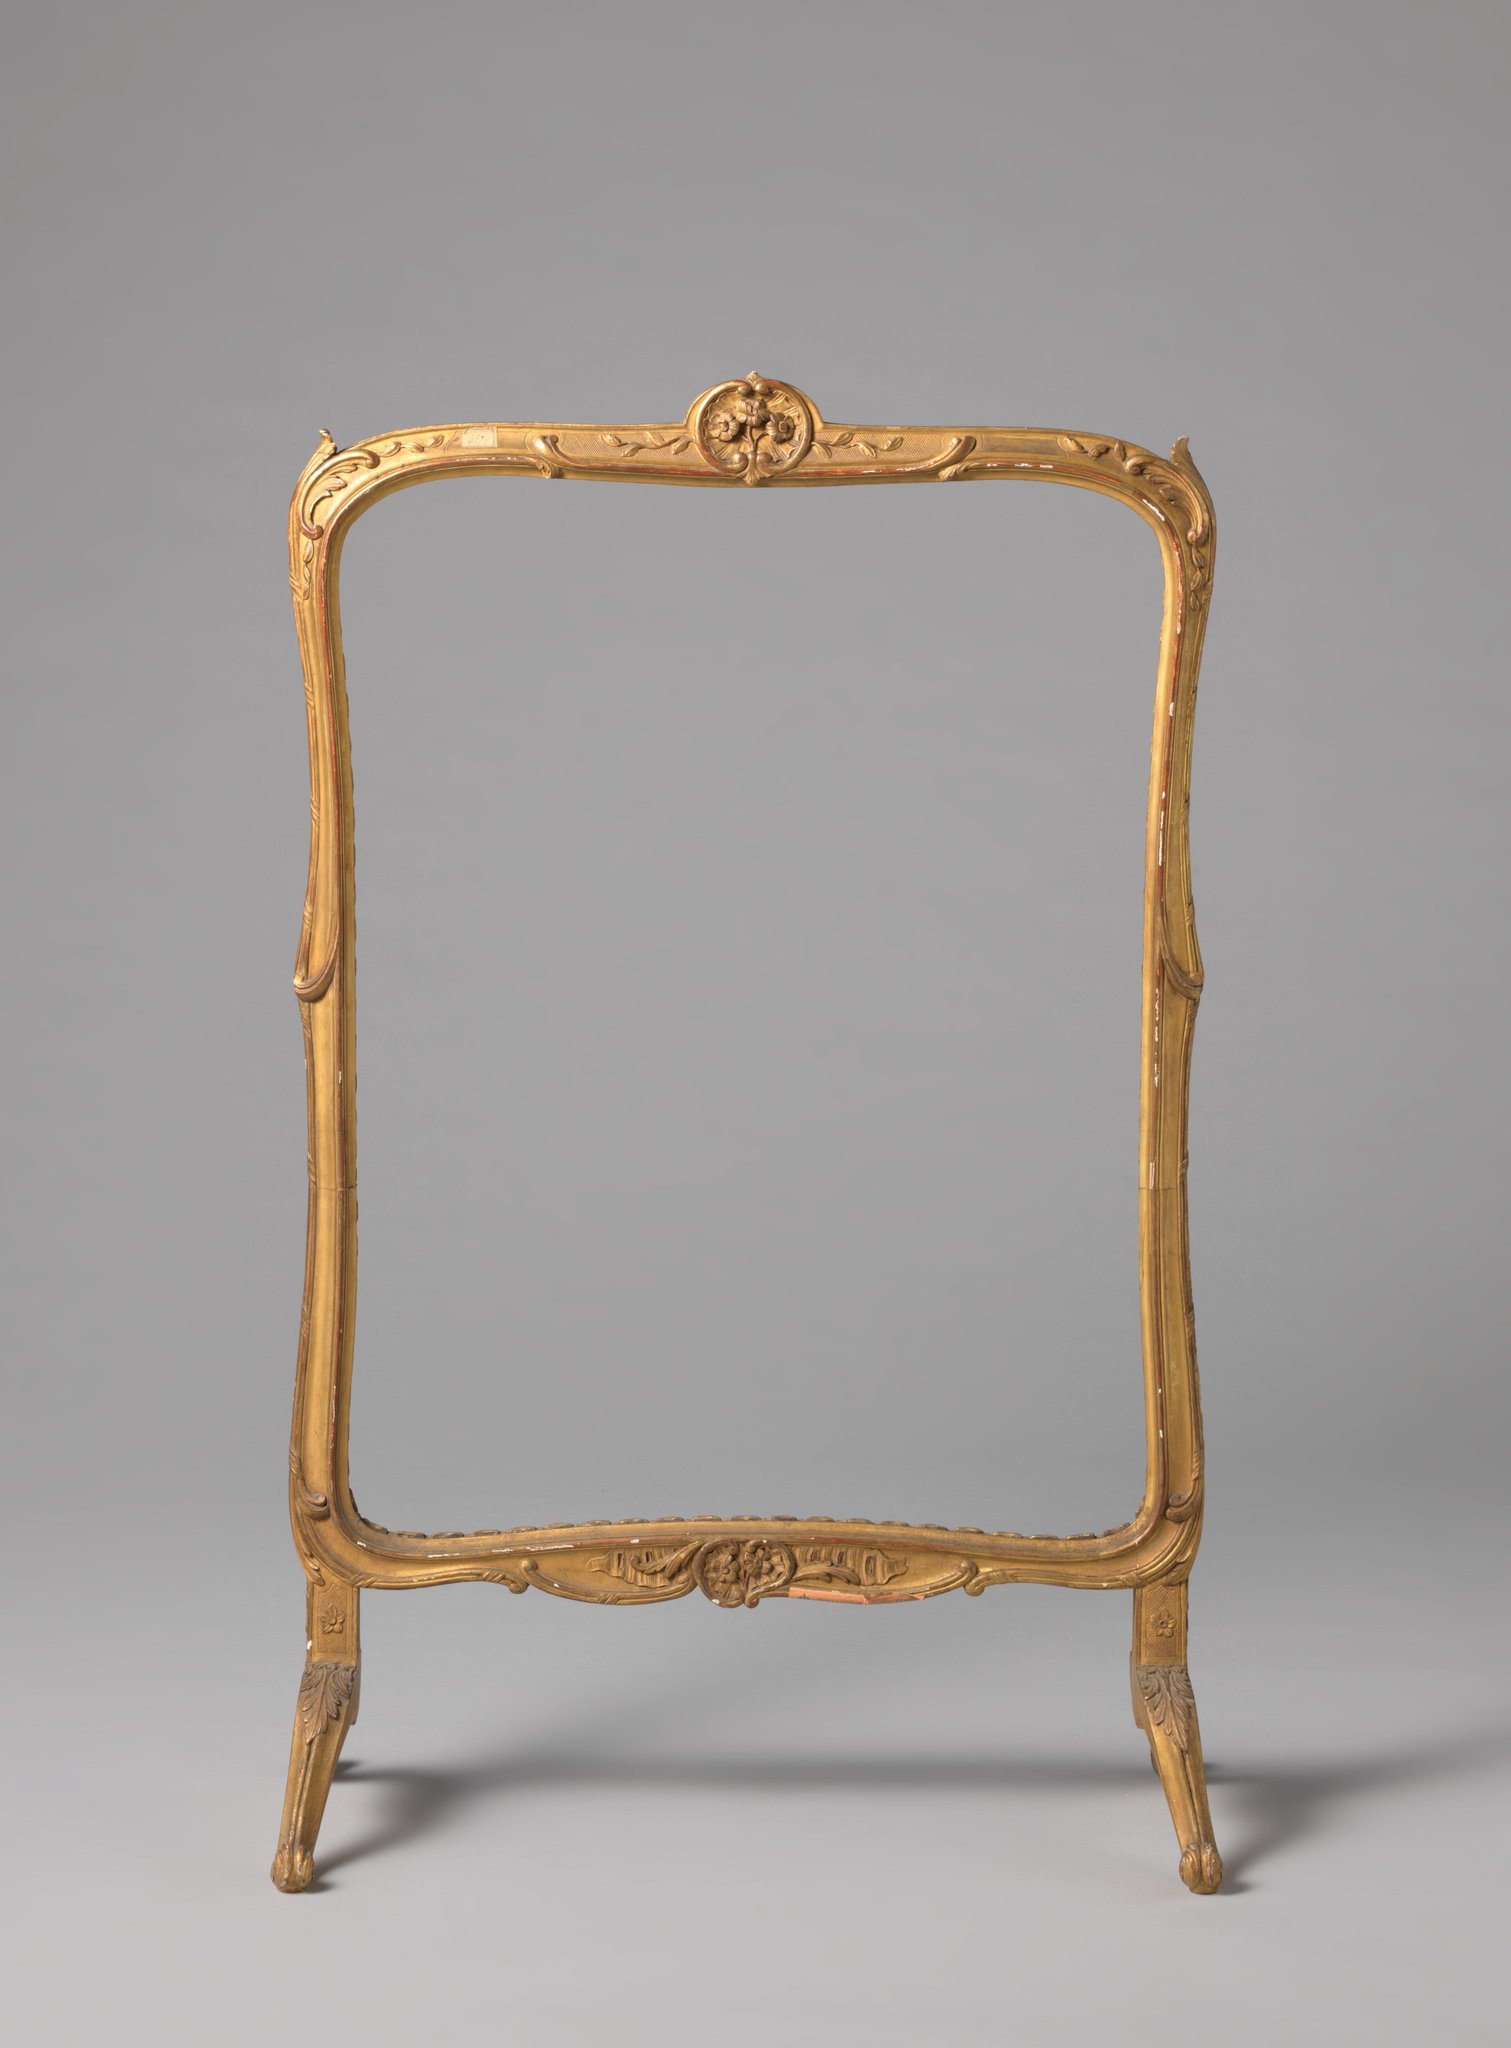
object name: fire screen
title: Vuurscherm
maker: Anonymous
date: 1850-1899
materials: wood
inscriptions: signature: ‘Neilson’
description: Vuurscherm van verguld beukenhout, met uitschuifblad. Het scherm rust op lage S-vormige schraagvoeten en heeft een raam met rocaille-motieven en bloemtakjes. Nieuw(?) gemaakt bij tapisserie (BK-16675-2).